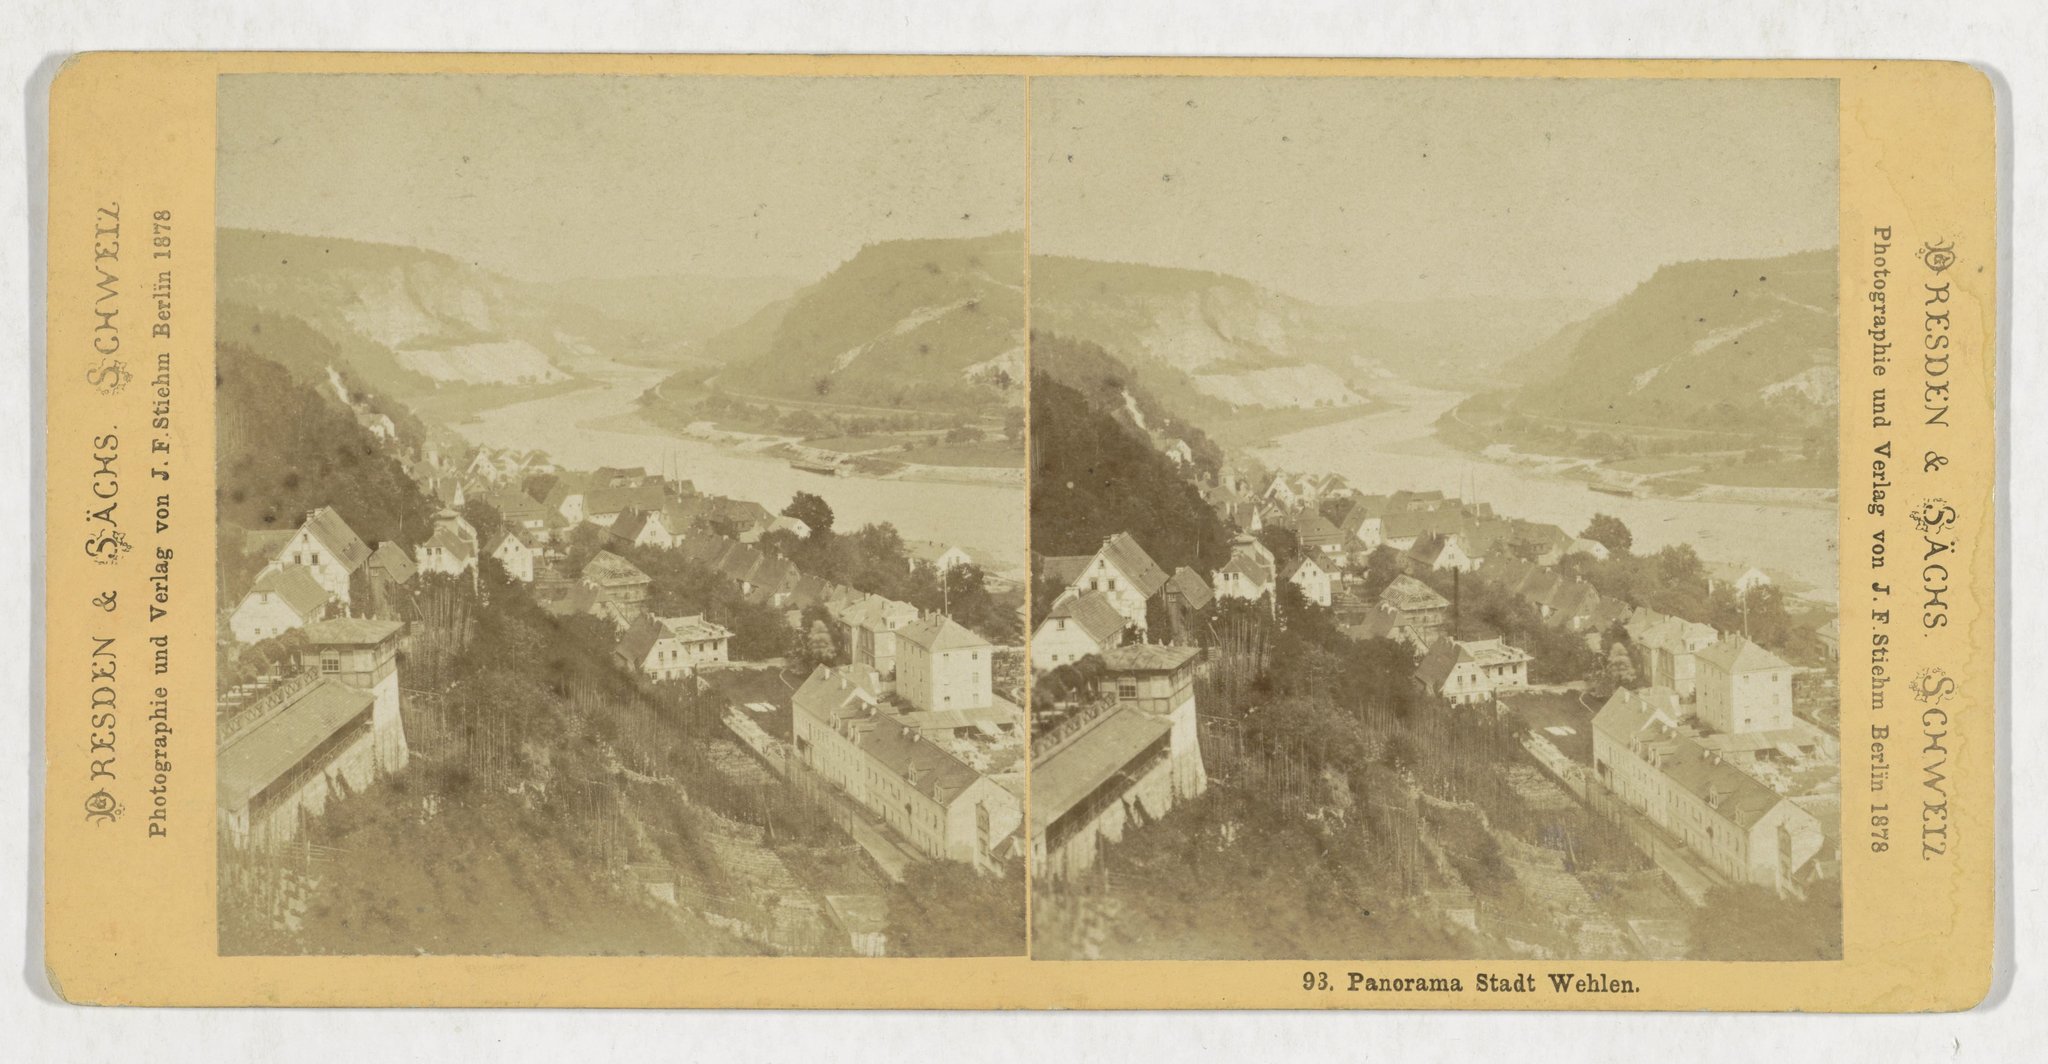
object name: stereograph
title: Panorama Stadt Wehlen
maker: johann friedrich stiehm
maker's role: fotograaf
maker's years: 1826-1902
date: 1878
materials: cardboard, paper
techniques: albumen print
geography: stadt wehlen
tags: city-view in general; 'veduta', river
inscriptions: number: ‘93.’